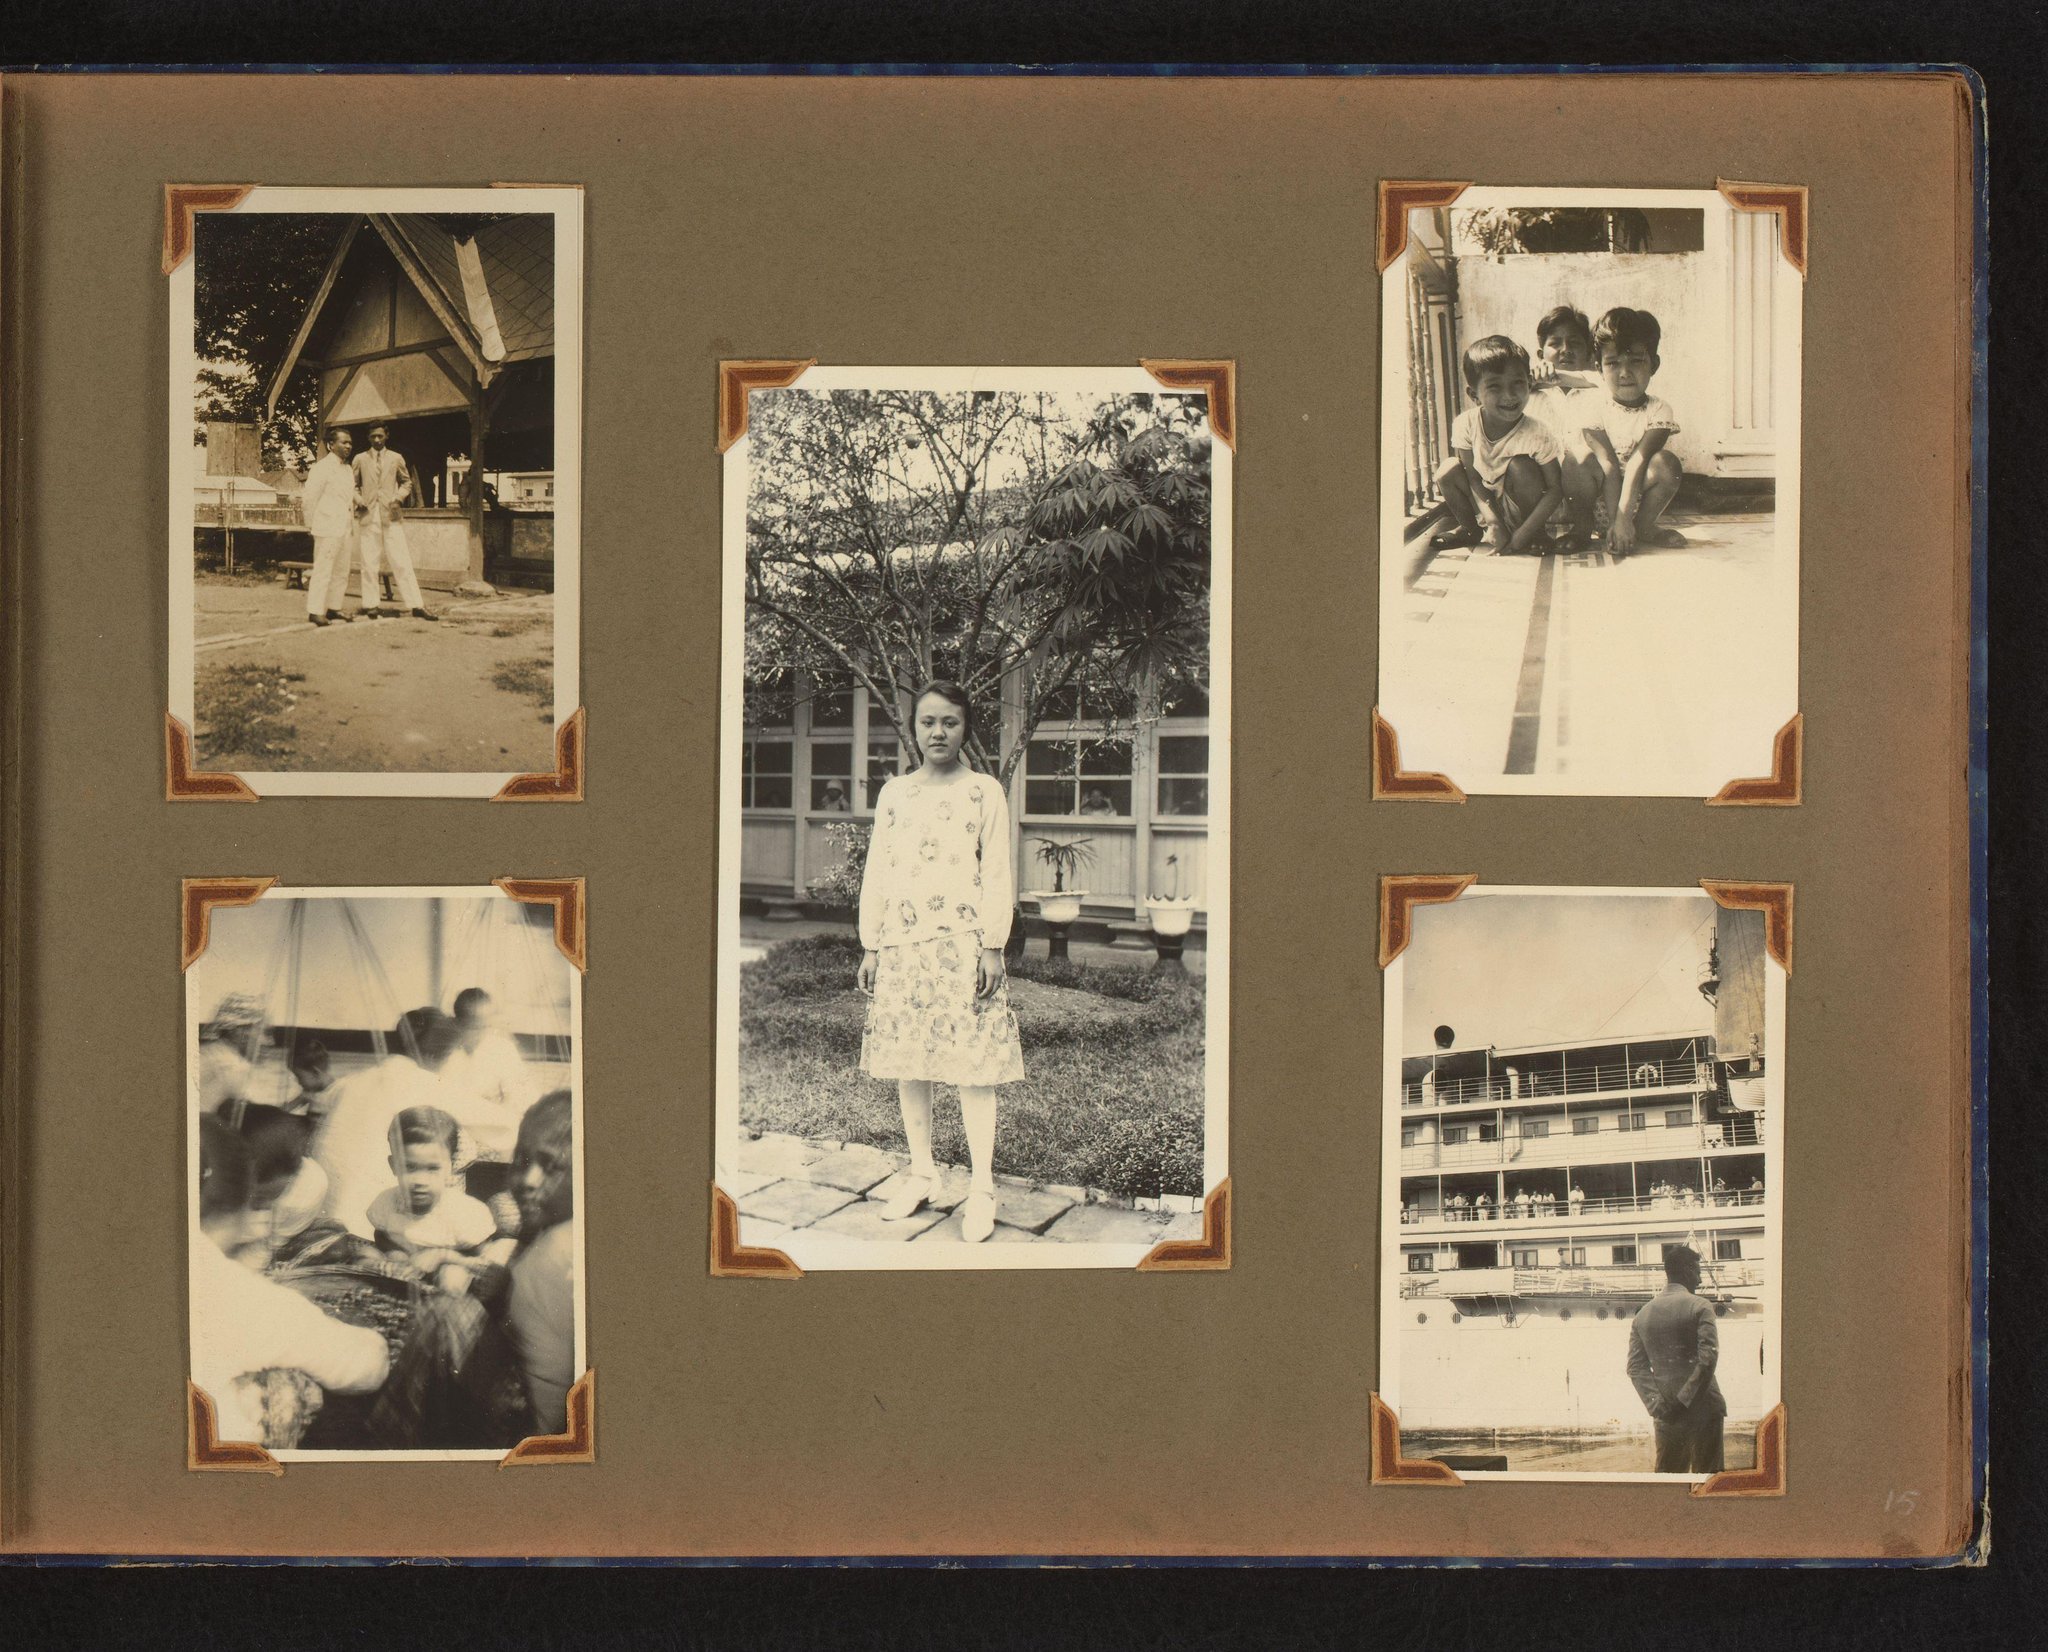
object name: photograph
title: Familie en vrienden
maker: Anonymous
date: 1928-1936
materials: cardboard, photographic support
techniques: gelatin silver print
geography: indonesia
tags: family life at home, batavia, indonesia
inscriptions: inscription: ‘Bzg 23 Oct '28 / Ter herinnering aan je nicht Enny To / Dit kiekje is genomen achter ons huis op Tjiandjoer’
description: Albumblad met zes foto's van familie en vrienden. Twee afdrukken van de foto van twee mannen voor een gebouw. De foto van een staande jonge vrouw is van een nicht en is in 1928 gemaakt in Buitenzorg. Onderdeel van een familiealbum van een Chinees-Indische familie in Weltevreden, ca. 1935.